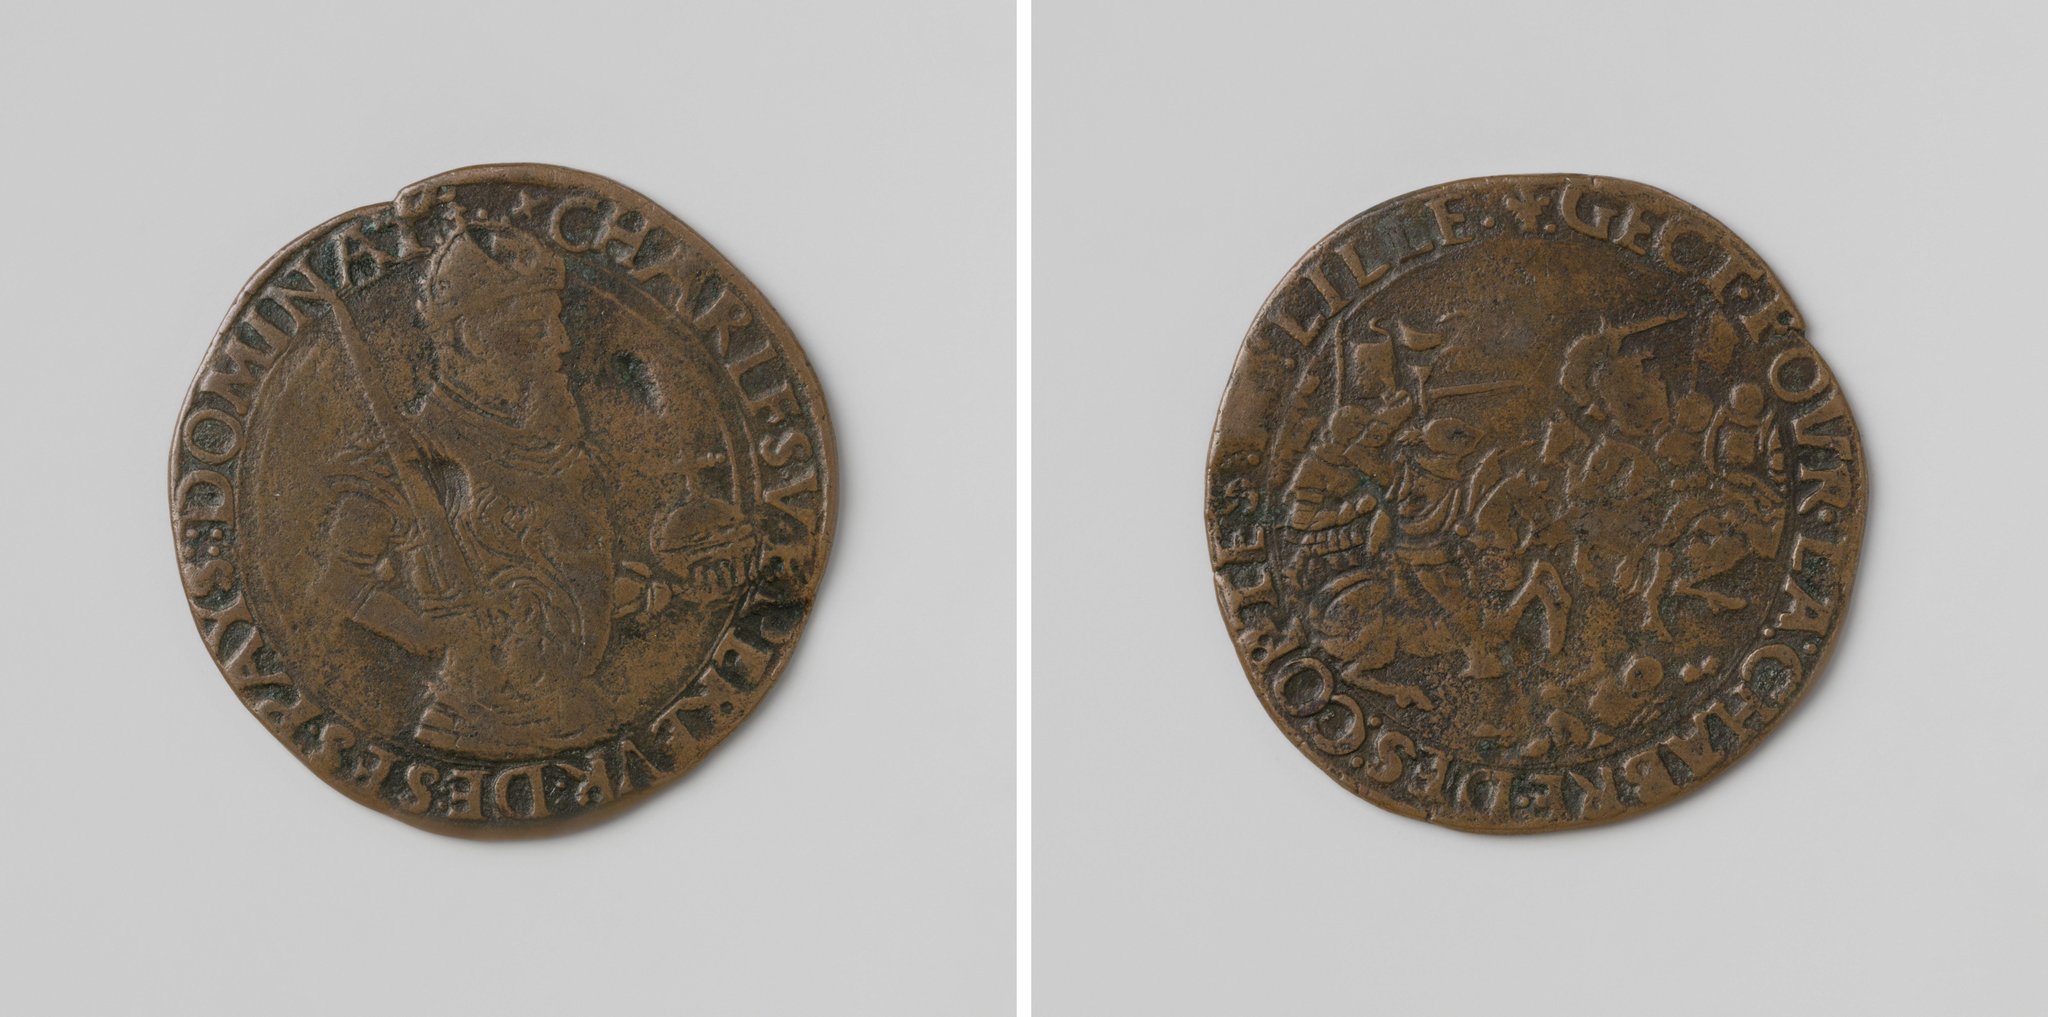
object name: jeton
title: Karel V, Duits keizer, bereidt zich voor op de oorlog tegen Frankrijk en Gelderland, rekenpenning voor de rekenkamer van Vlaanderen te Rijssel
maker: Anonymous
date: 1543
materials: copper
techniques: striking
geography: flanders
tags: ghent, charles v (holy roman emperor and king of spain), lille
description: Koperen penning. Voorzijde: portret van Karel V met kroon, rijksappel in linkerhand en zwaard over rechterschouder binnen omschrift. Keerzijde: ruitergevecht binnen omschrift